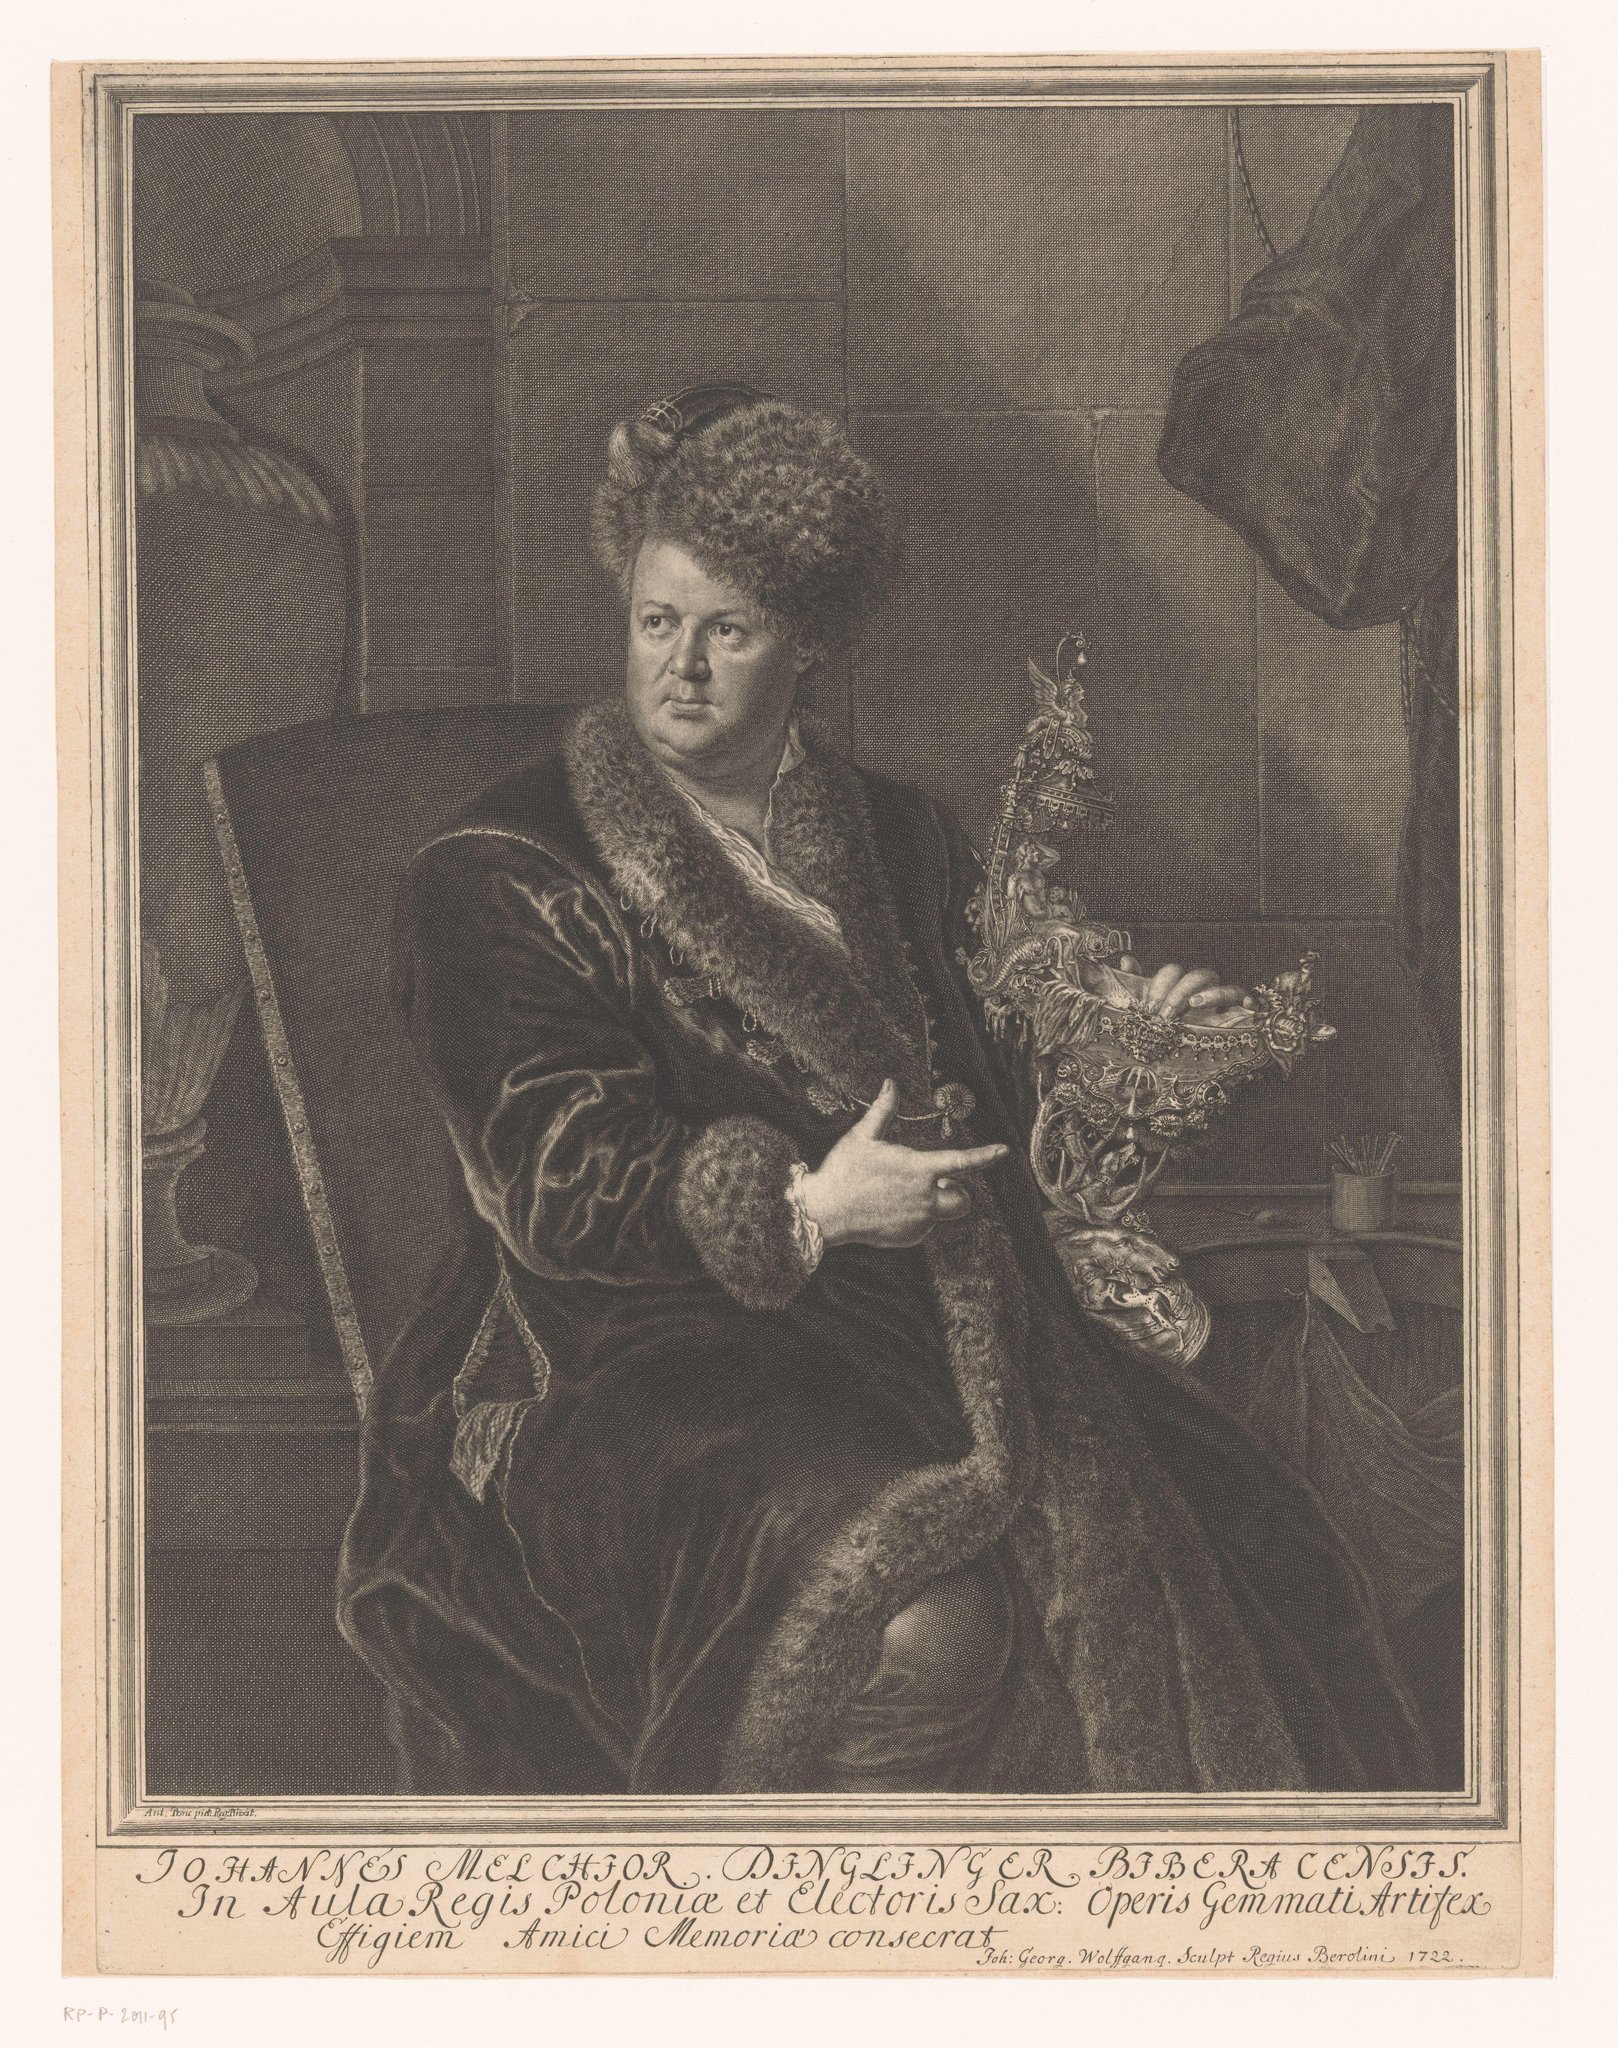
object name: print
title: Portret van goudsmid Johann Melchior Dinglinger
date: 1722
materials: paper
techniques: engraving, etching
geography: berlin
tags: goldsmith, johann melchior dinglinger, actaeon as a stag is devoured by his own dogs, 'trionfi di tavola', 'pièces montées', historical persons, jeweller, goldsmith, silversmith, diana bathing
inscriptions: collector's mark: Lugt 2760, collector's mark: Lugt 2228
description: Portret van de goudsmid Melchior Dinglinger, gezeten in zijn werkplaats. Hij is gekleed in een met bont afgezette mantel en bijbehorende bontmuts en houdt in zijn hand een groot tafelstuk in neorenaissance stijl versierd met honden, herten en jacht attributen.